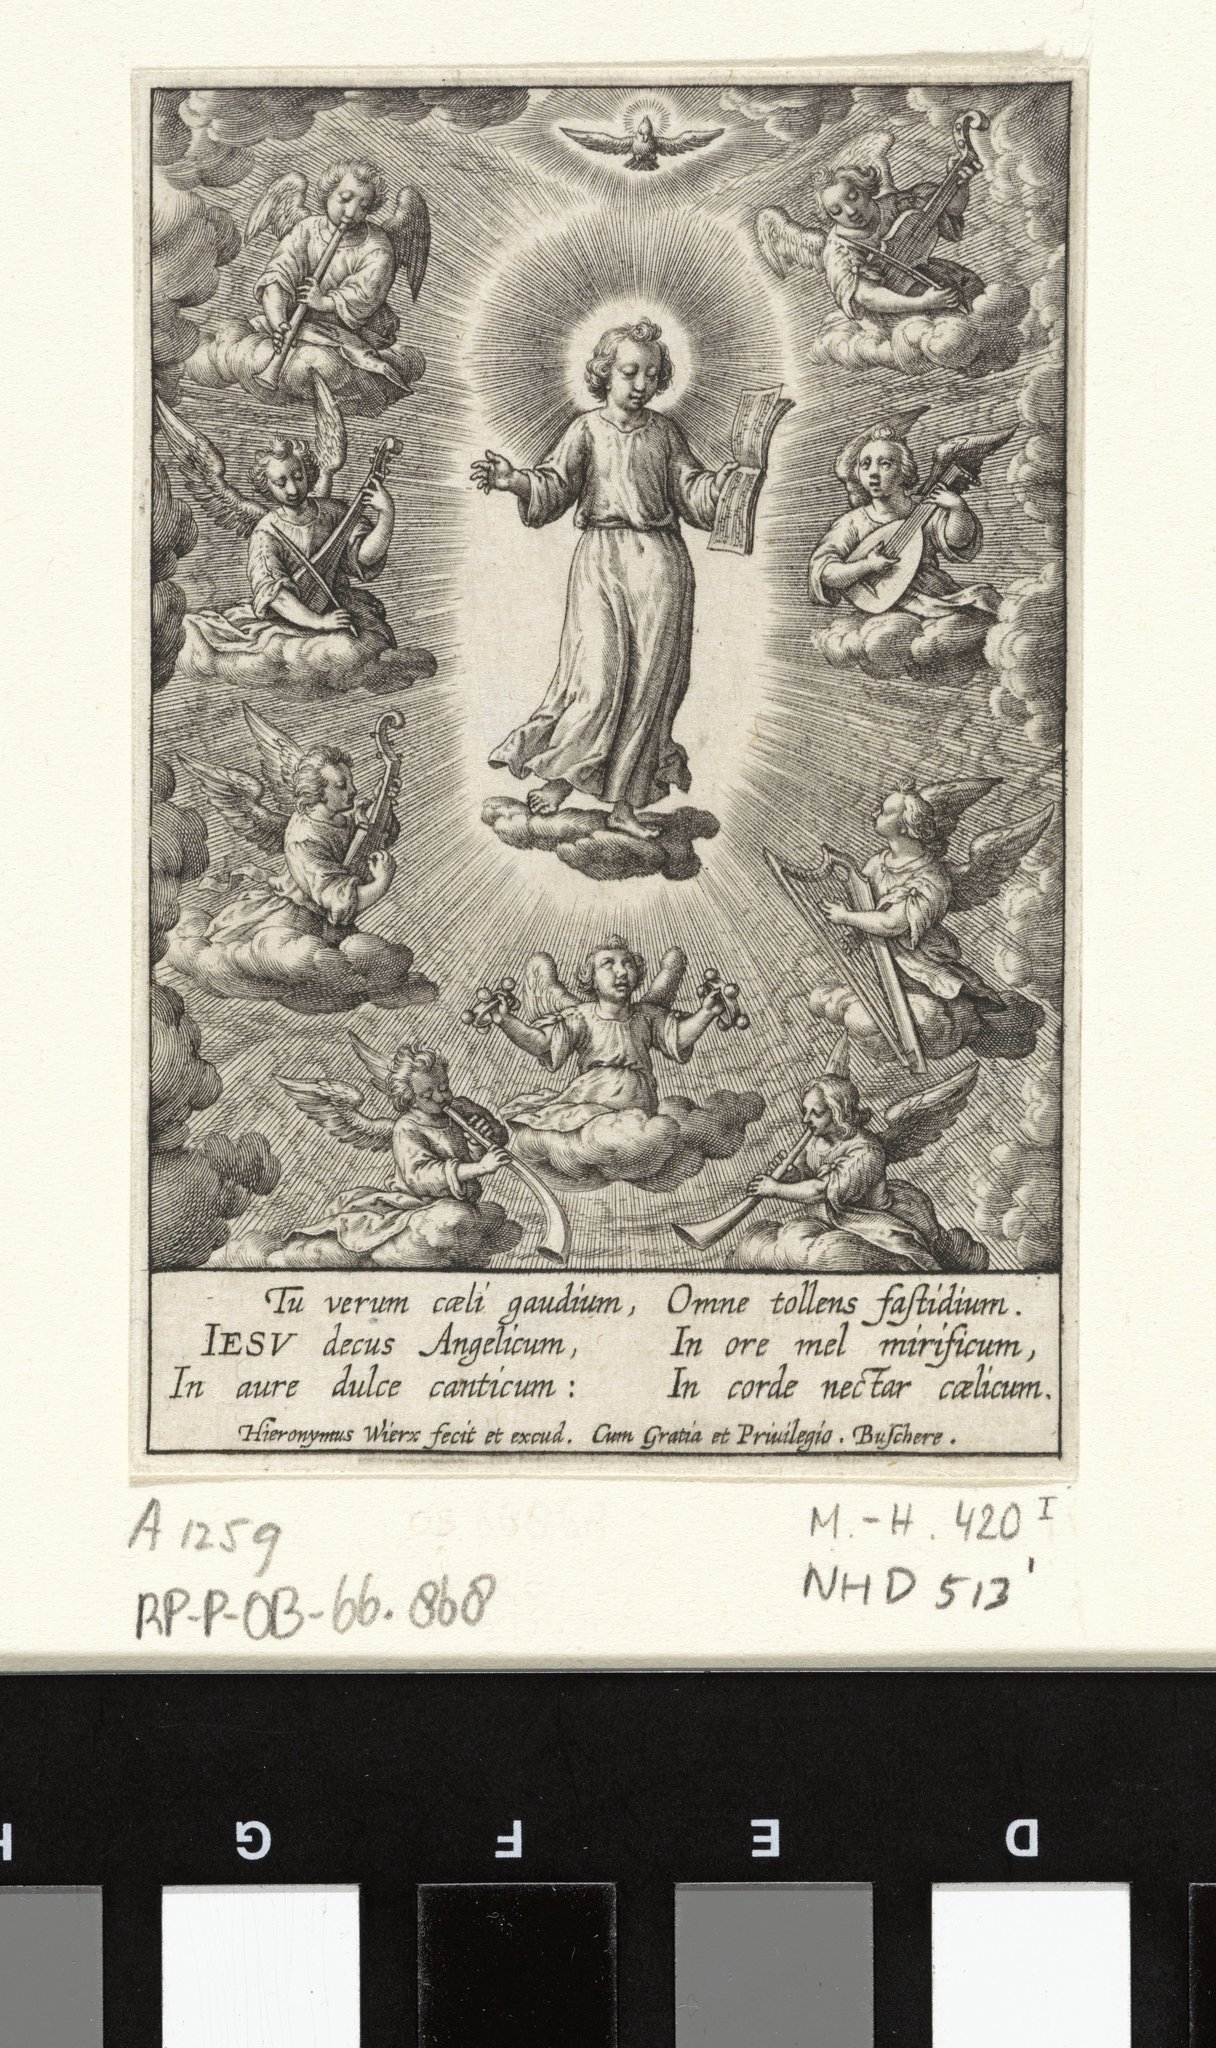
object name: print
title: Aanbidding van het Christuskind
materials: paper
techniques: engraving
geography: antwerp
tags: christ-child (with attributes), angels in adoration, holy ghost represented as a dove (in flames)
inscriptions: collector's mark: Lugt 2228, number: ‘62’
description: Musicerende engelen aanbidden het Christuskind dat op een wolk staat met een liedboek in de hand. Boven het hoofd van het Kind de Heilige Geest in de gedaante van een duif. In de marge een zesregelig onderschrift, in twee kolommen, in het Latijn.